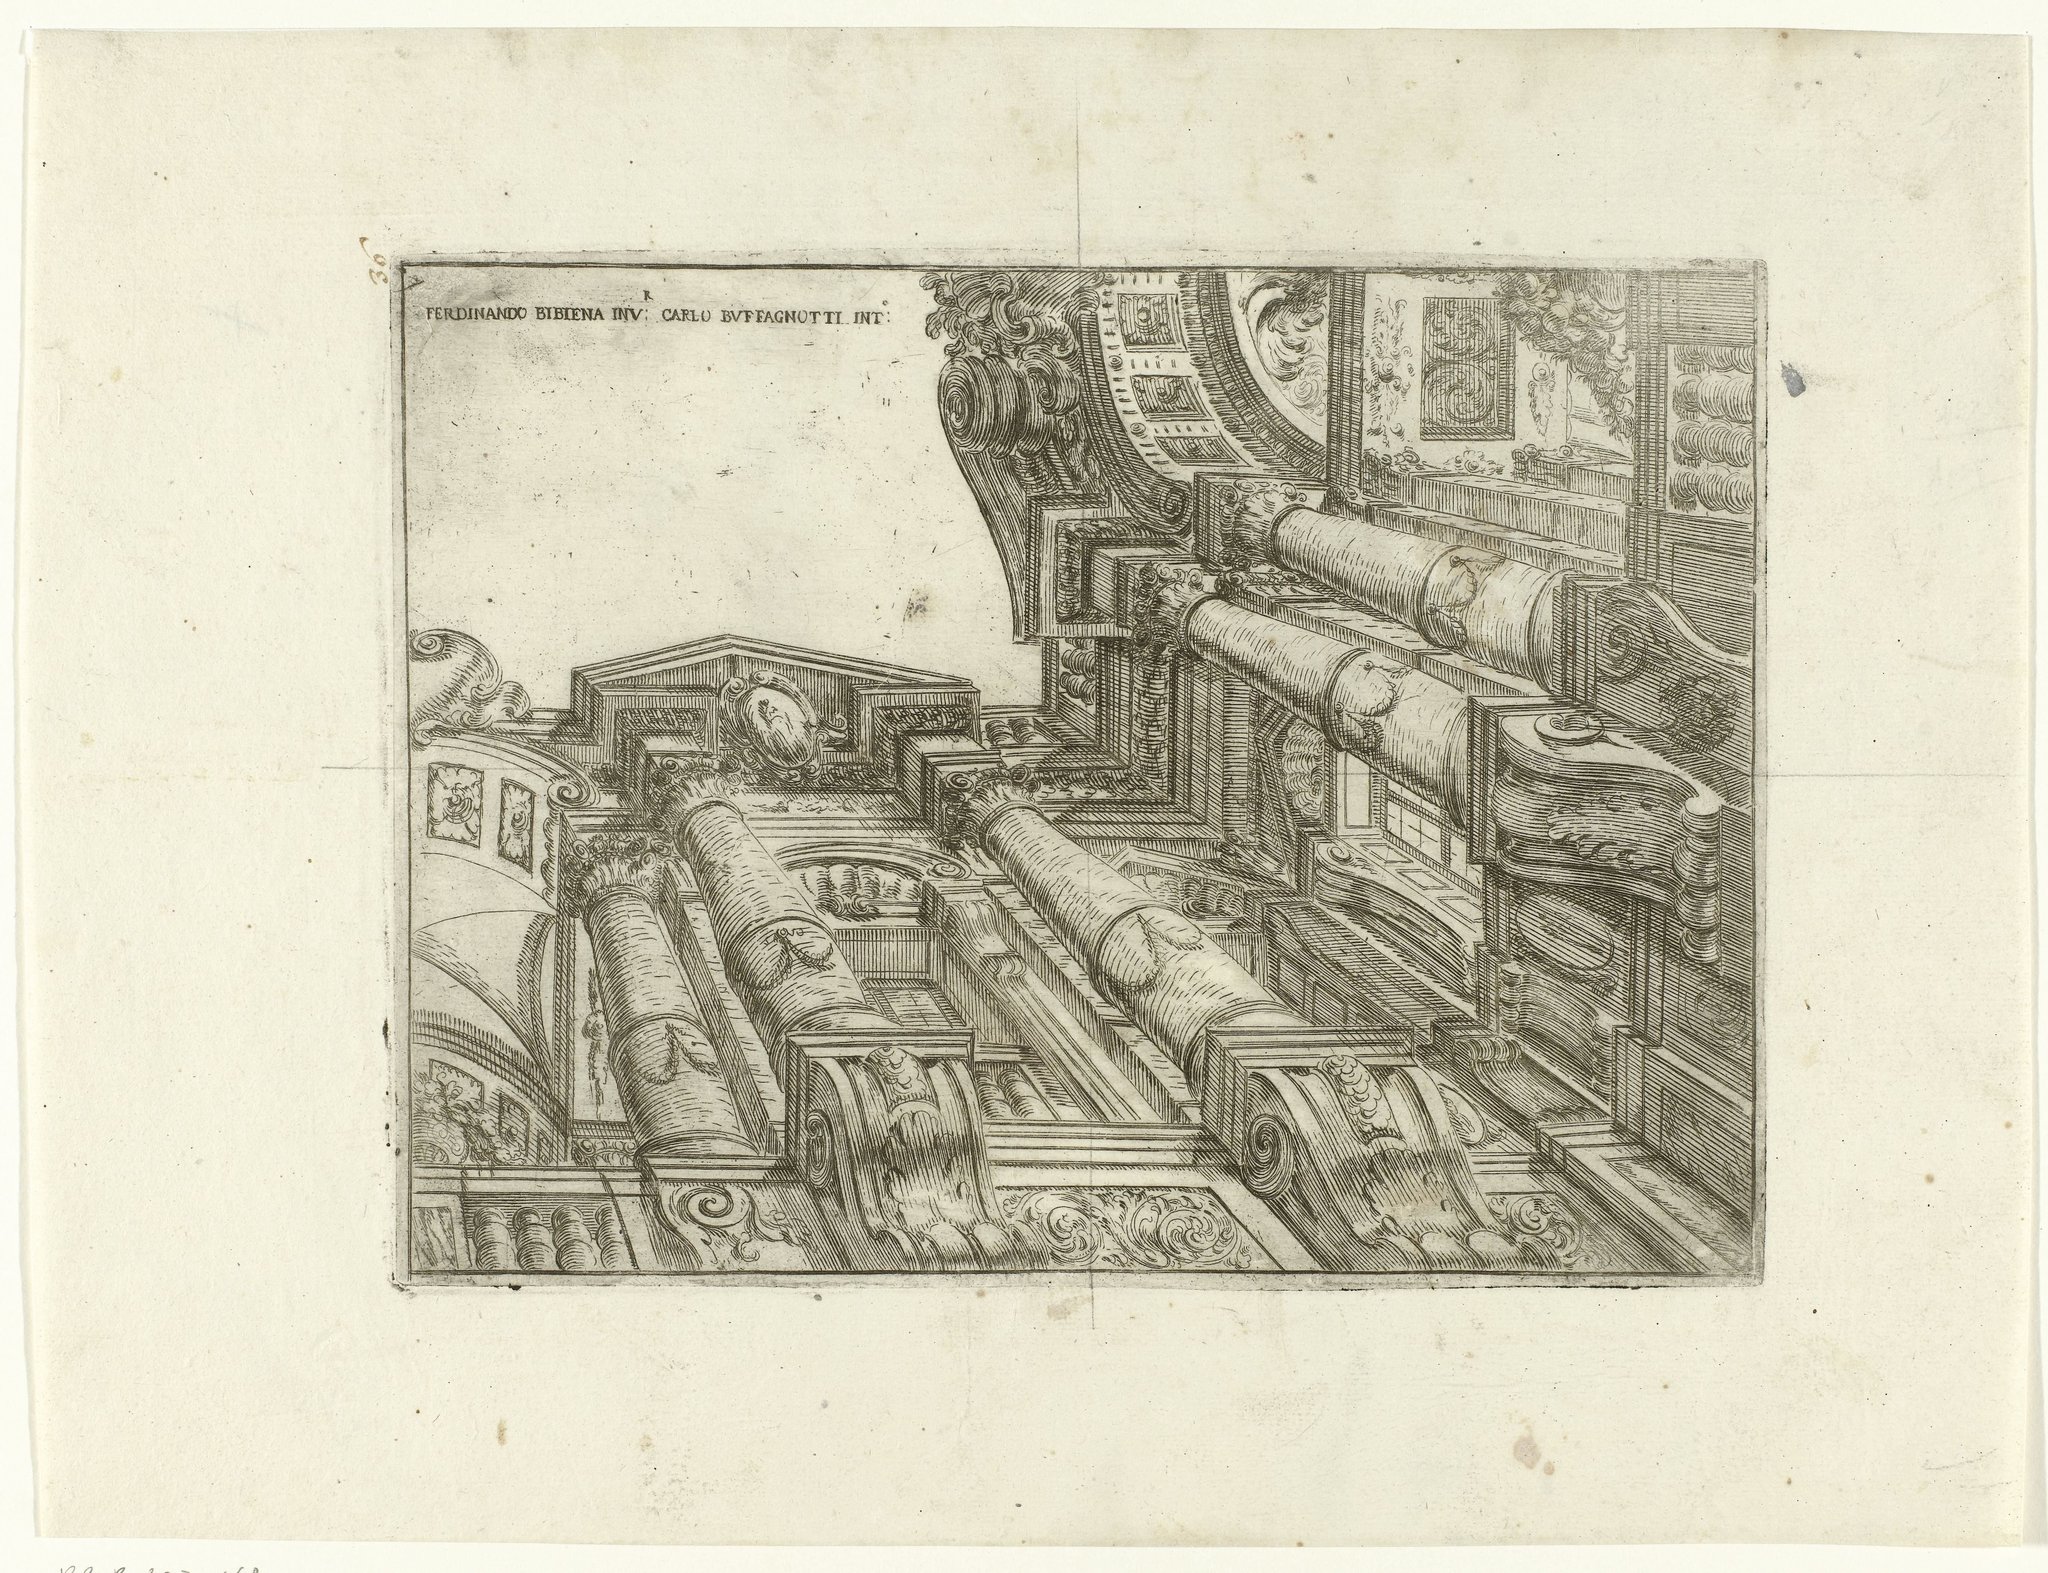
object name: print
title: Ontwerp voor een toneeldecor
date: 1707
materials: paper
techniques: etching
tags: theatre (building), stage design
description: Hoek tussen twee gevels met pilaren en veel ornamenten, van onderaf gezien.